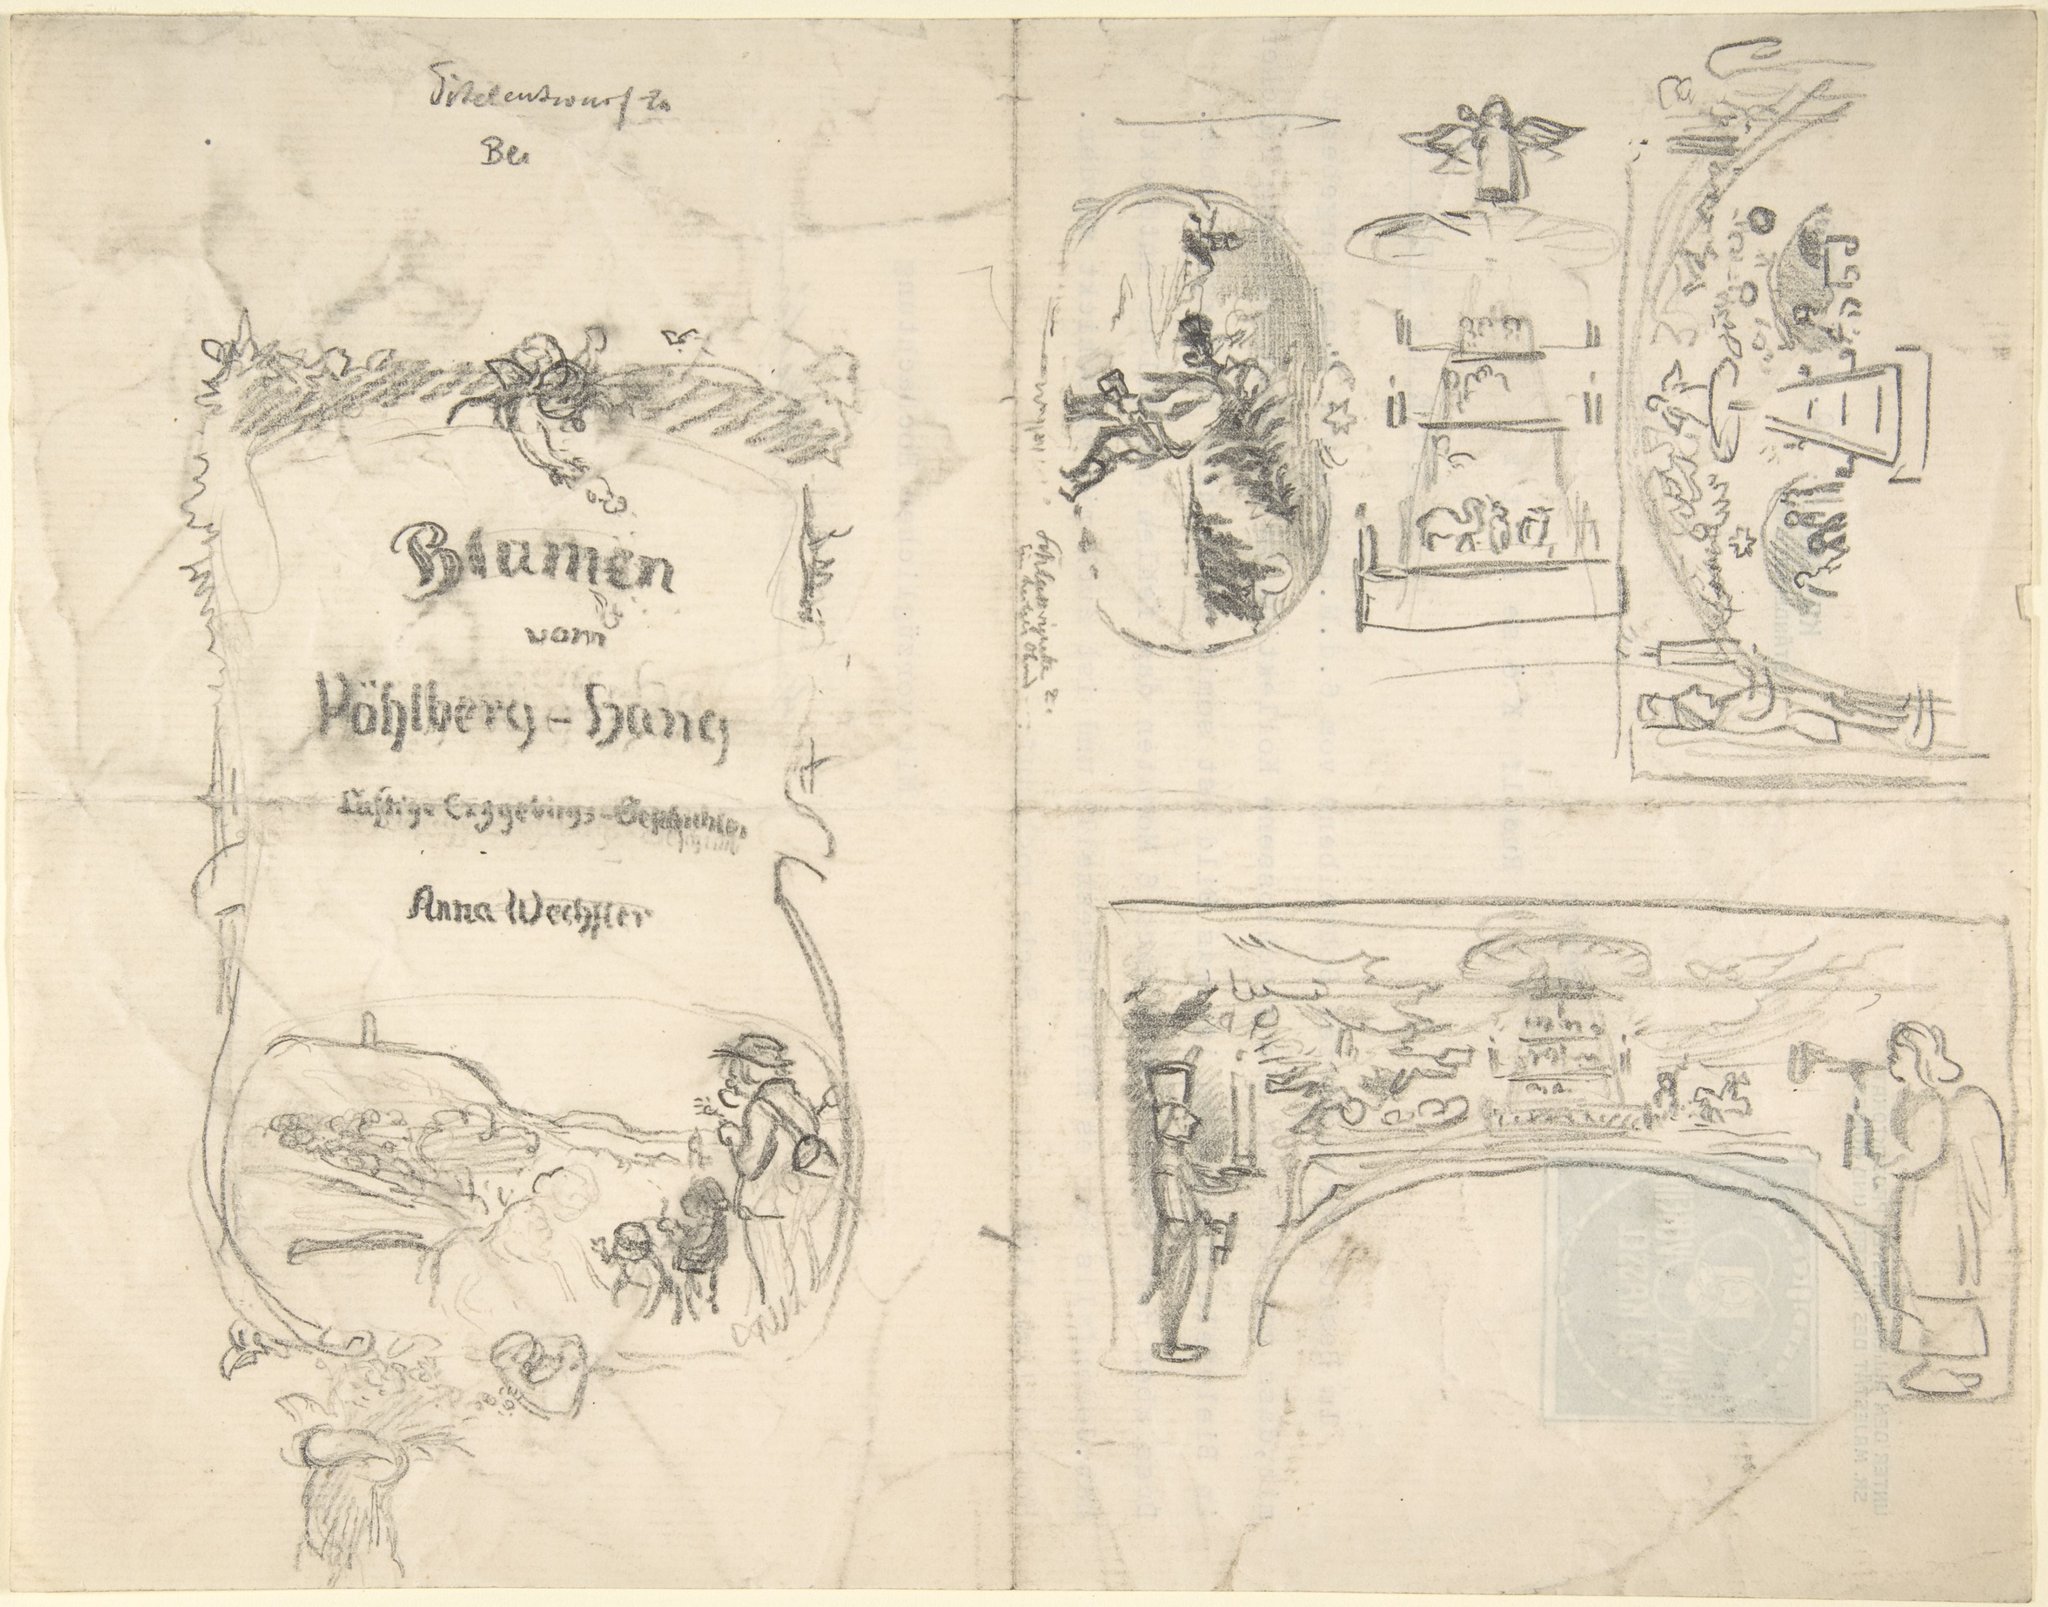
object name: drawing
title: Studies for the title page and vignettes for Blumen vom Pöhlberg-Hang by Anna Wechsler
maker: anonymous, german, 19th century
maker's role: artist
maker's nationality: german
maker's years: 1800-1899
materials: pencil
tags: men,women